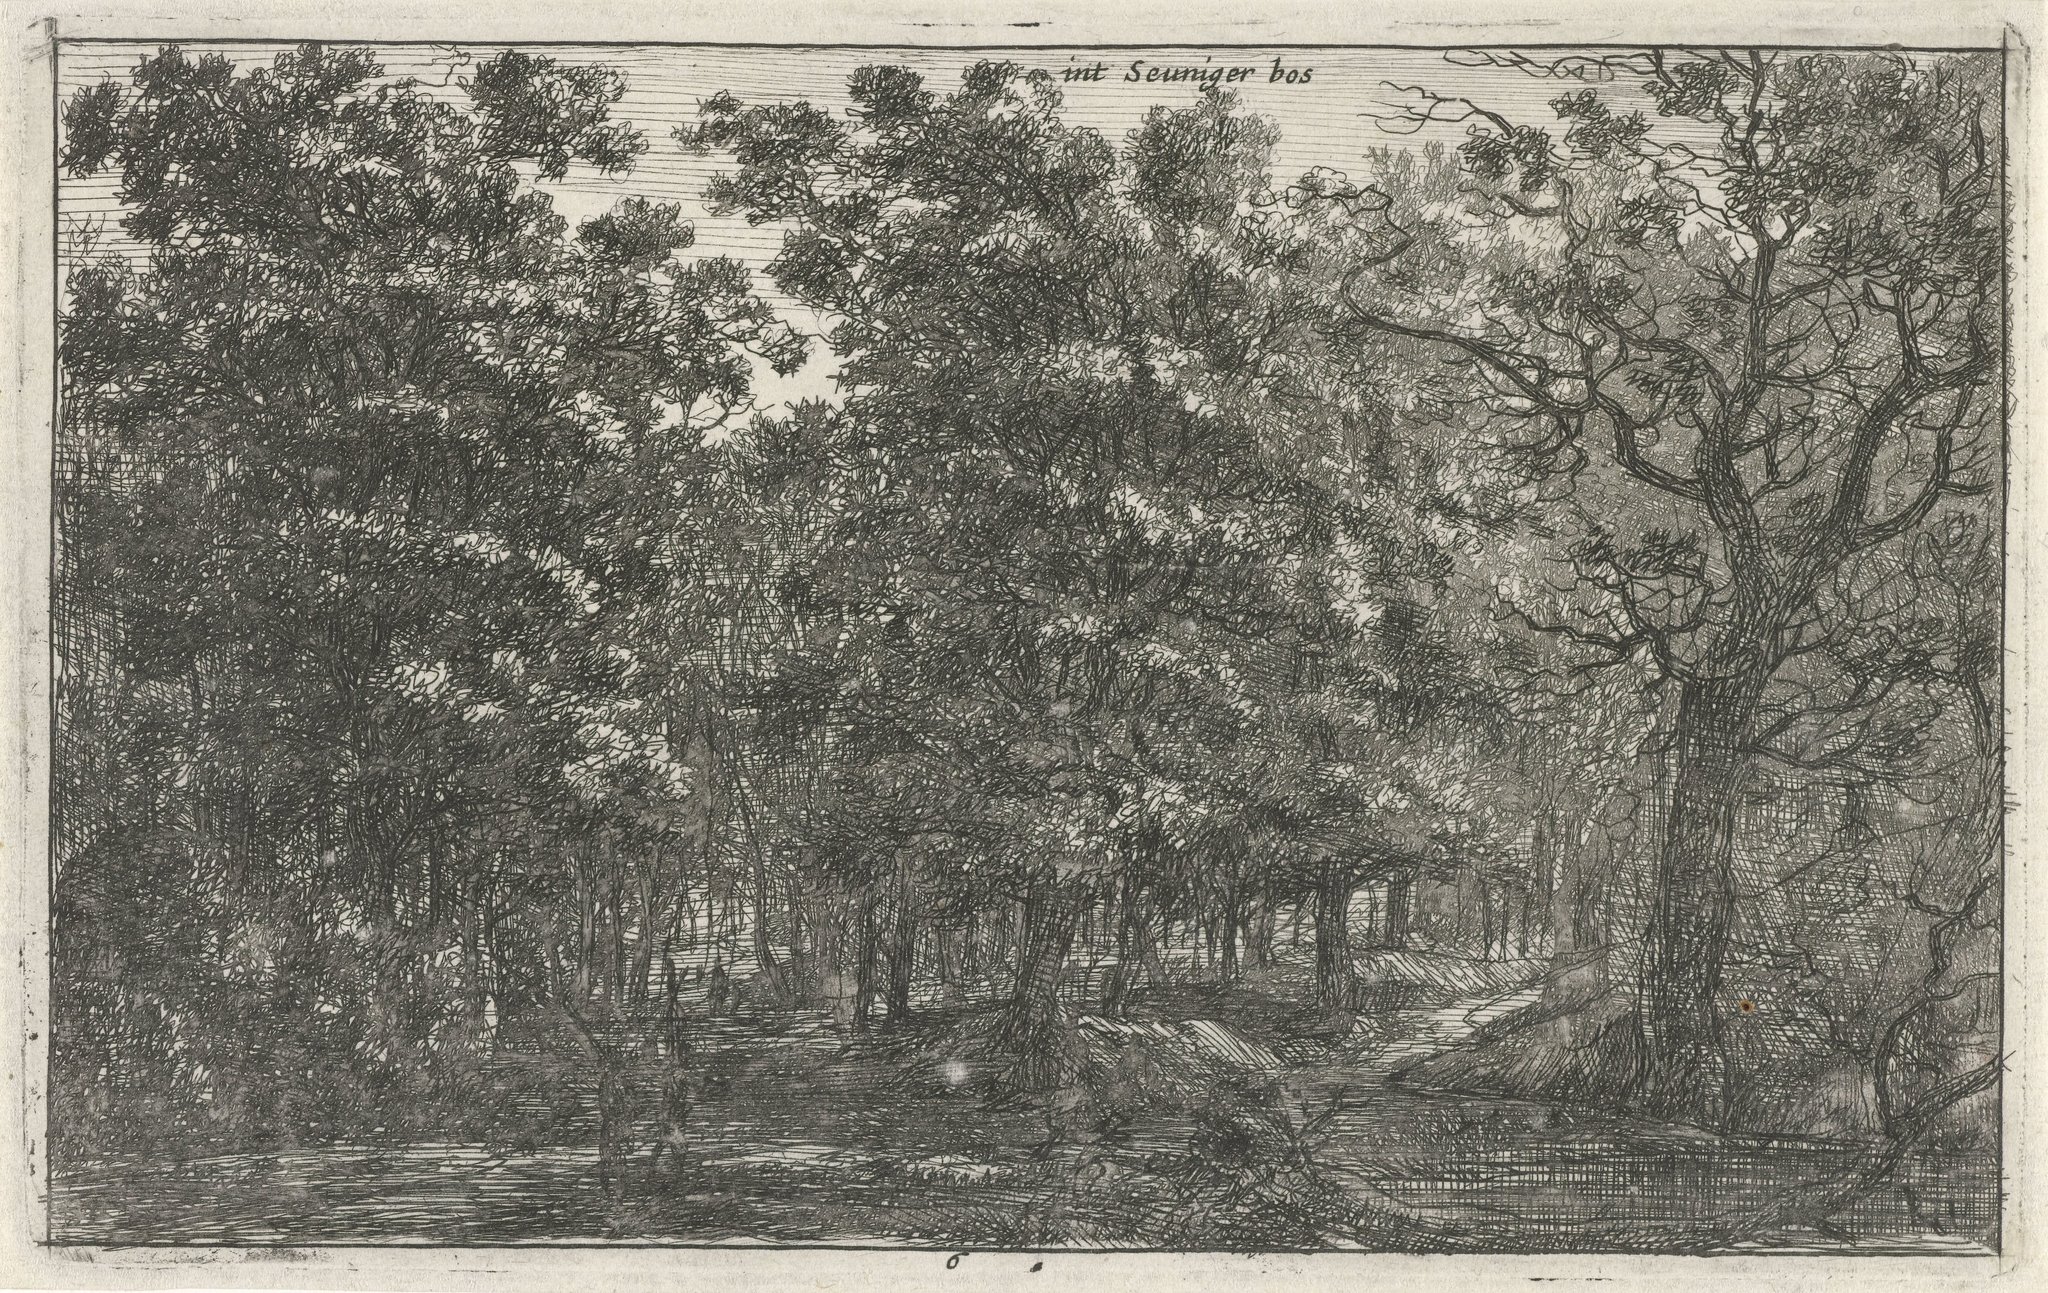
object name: print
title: int Seuniger bos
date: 1637-1677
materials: paper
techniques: drypoint, etching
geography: amsterdam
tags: forest, wood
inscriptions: collector's mark: Lugt 240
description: Gezicht op een open plek in het Seuniger bos, mogelijk het Zoniënwoud bij Brussel. Genummerd onderaan in de marge: 8.